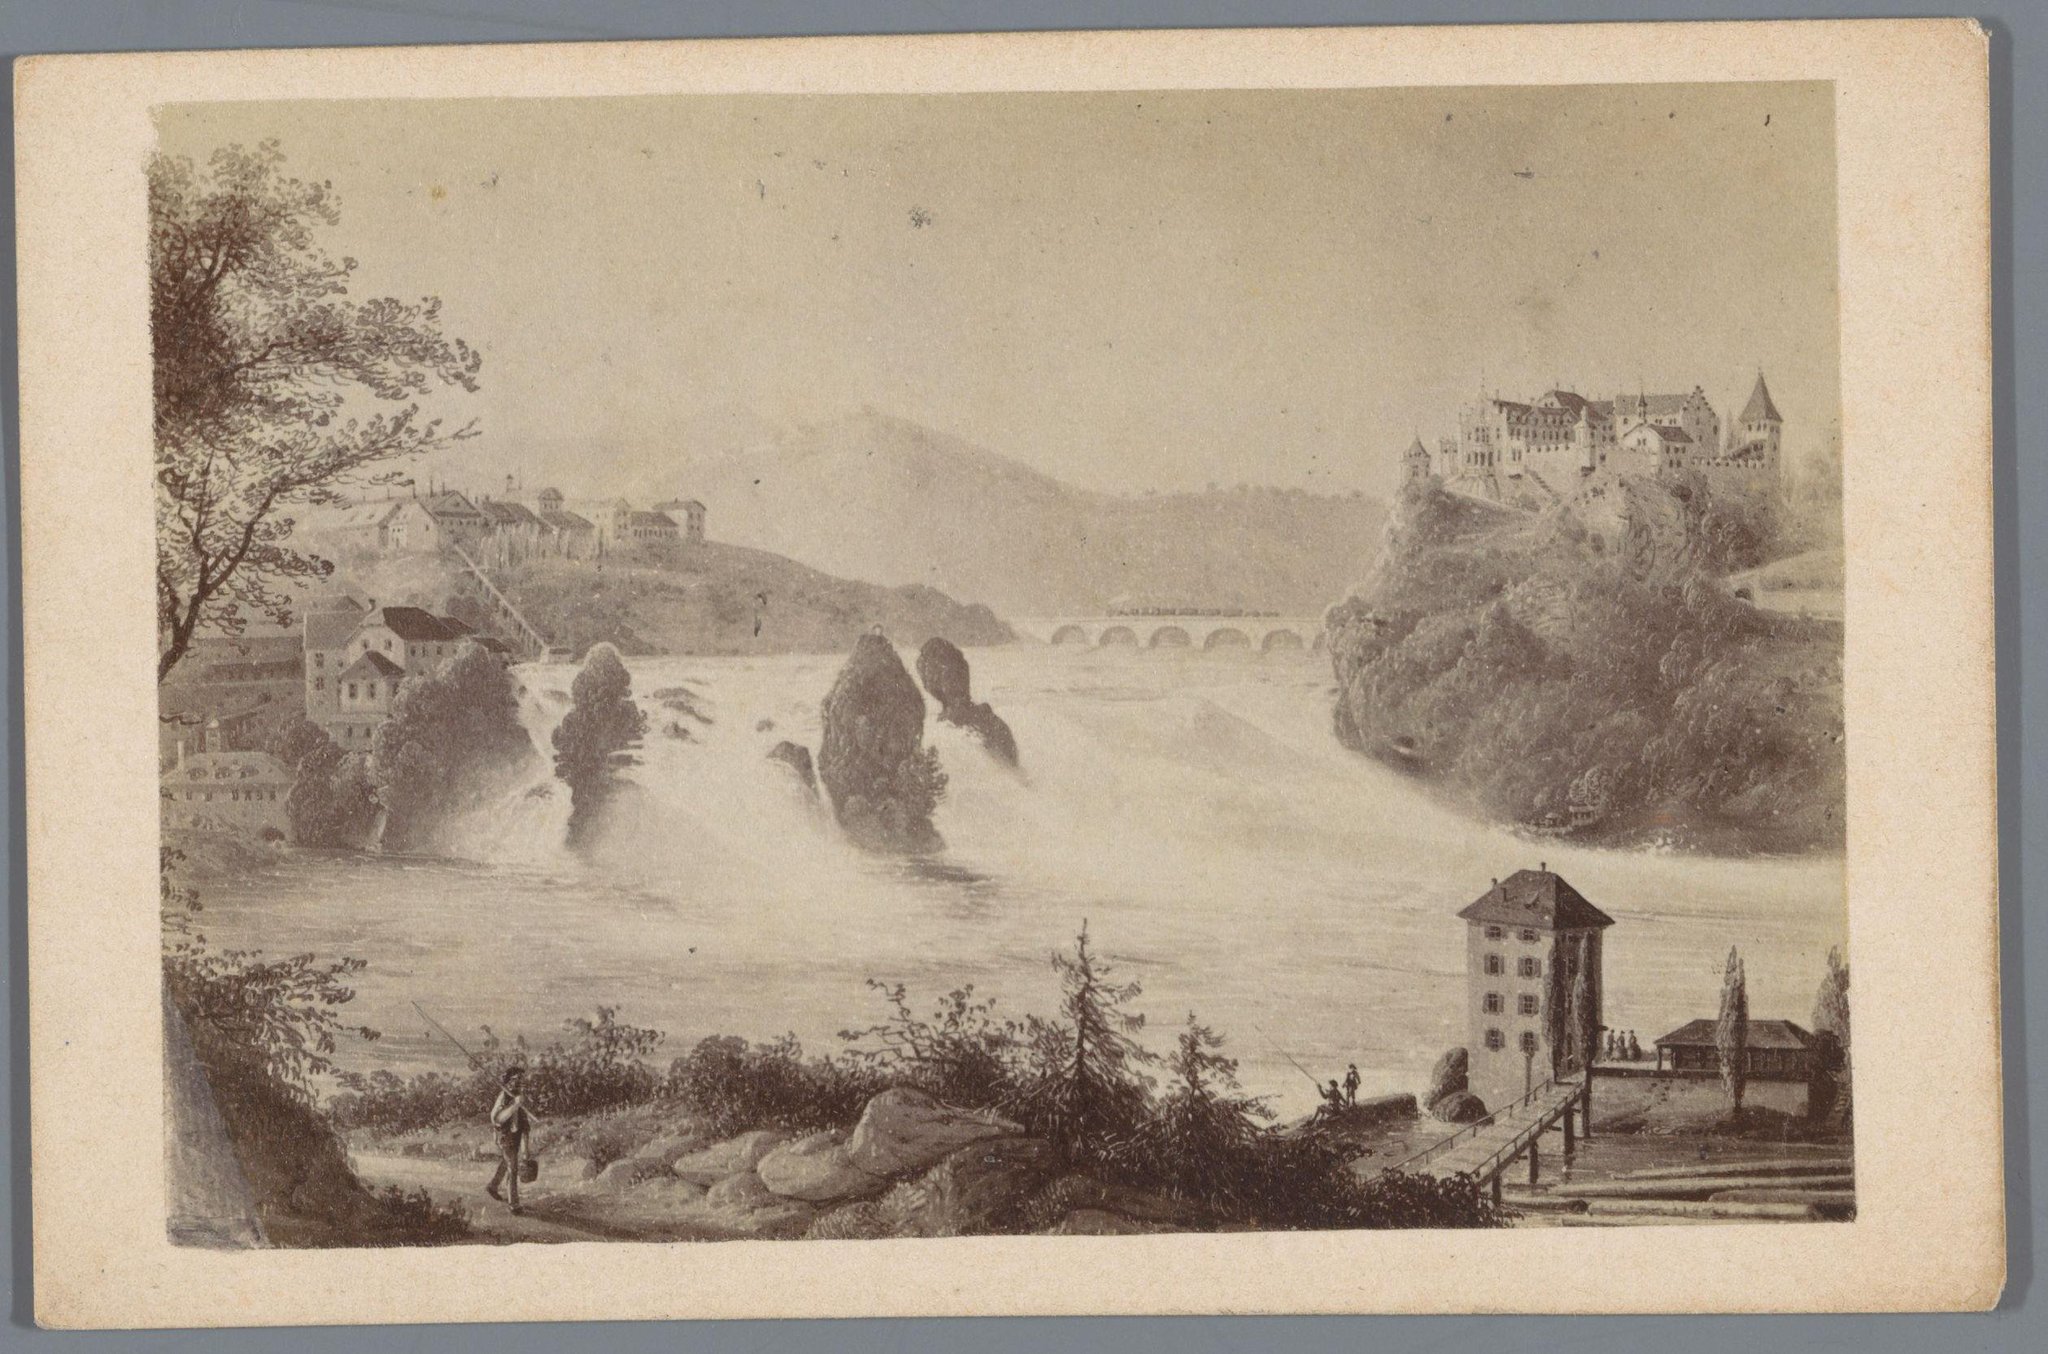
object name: photograph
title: Fotoreproductie van een schilderij van de Rheinfall nabij Schaffhausen, Zwitserland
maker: Anonymous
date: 1854-1885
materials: cardboard, paper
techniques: albumen print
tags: waterfall